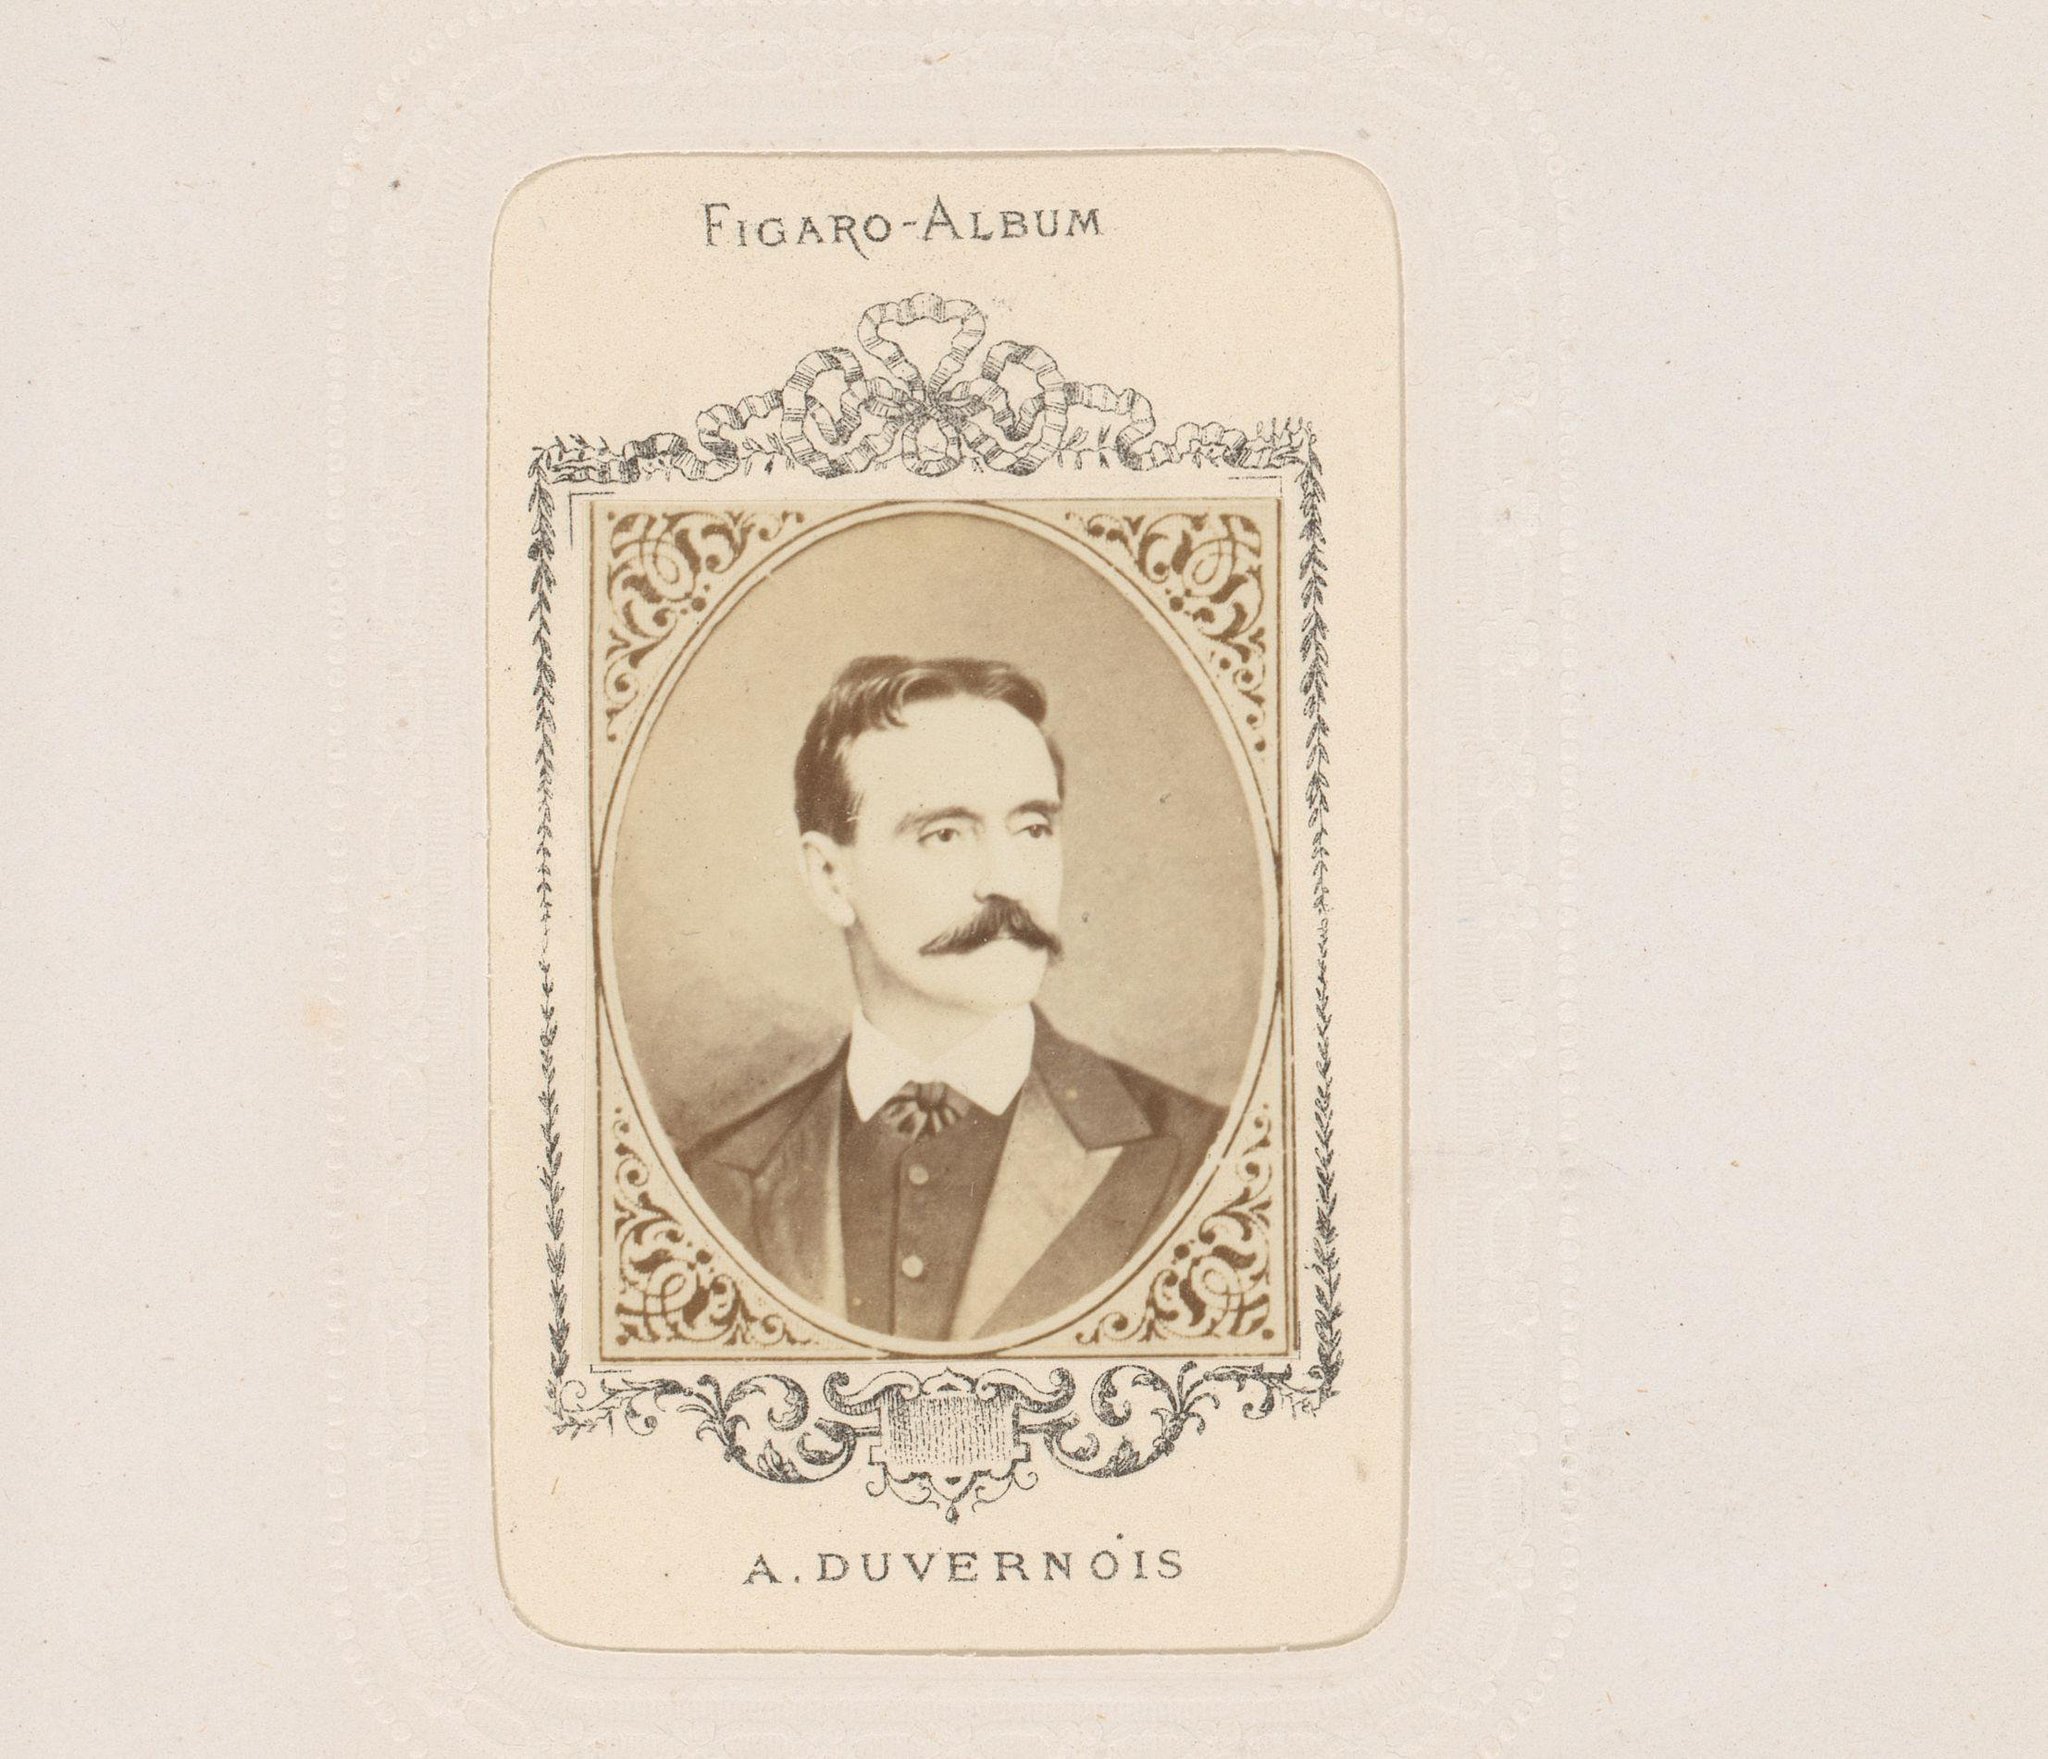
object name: reproduction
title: Fotoreproductie van een portret van A. Duvernois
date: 1860-1900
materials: cardboard, photographic support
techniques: albumen print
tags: historical persons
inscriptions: inscription: ‘Figaro-Album/ A. Duvernois/ Liébert Phot.’